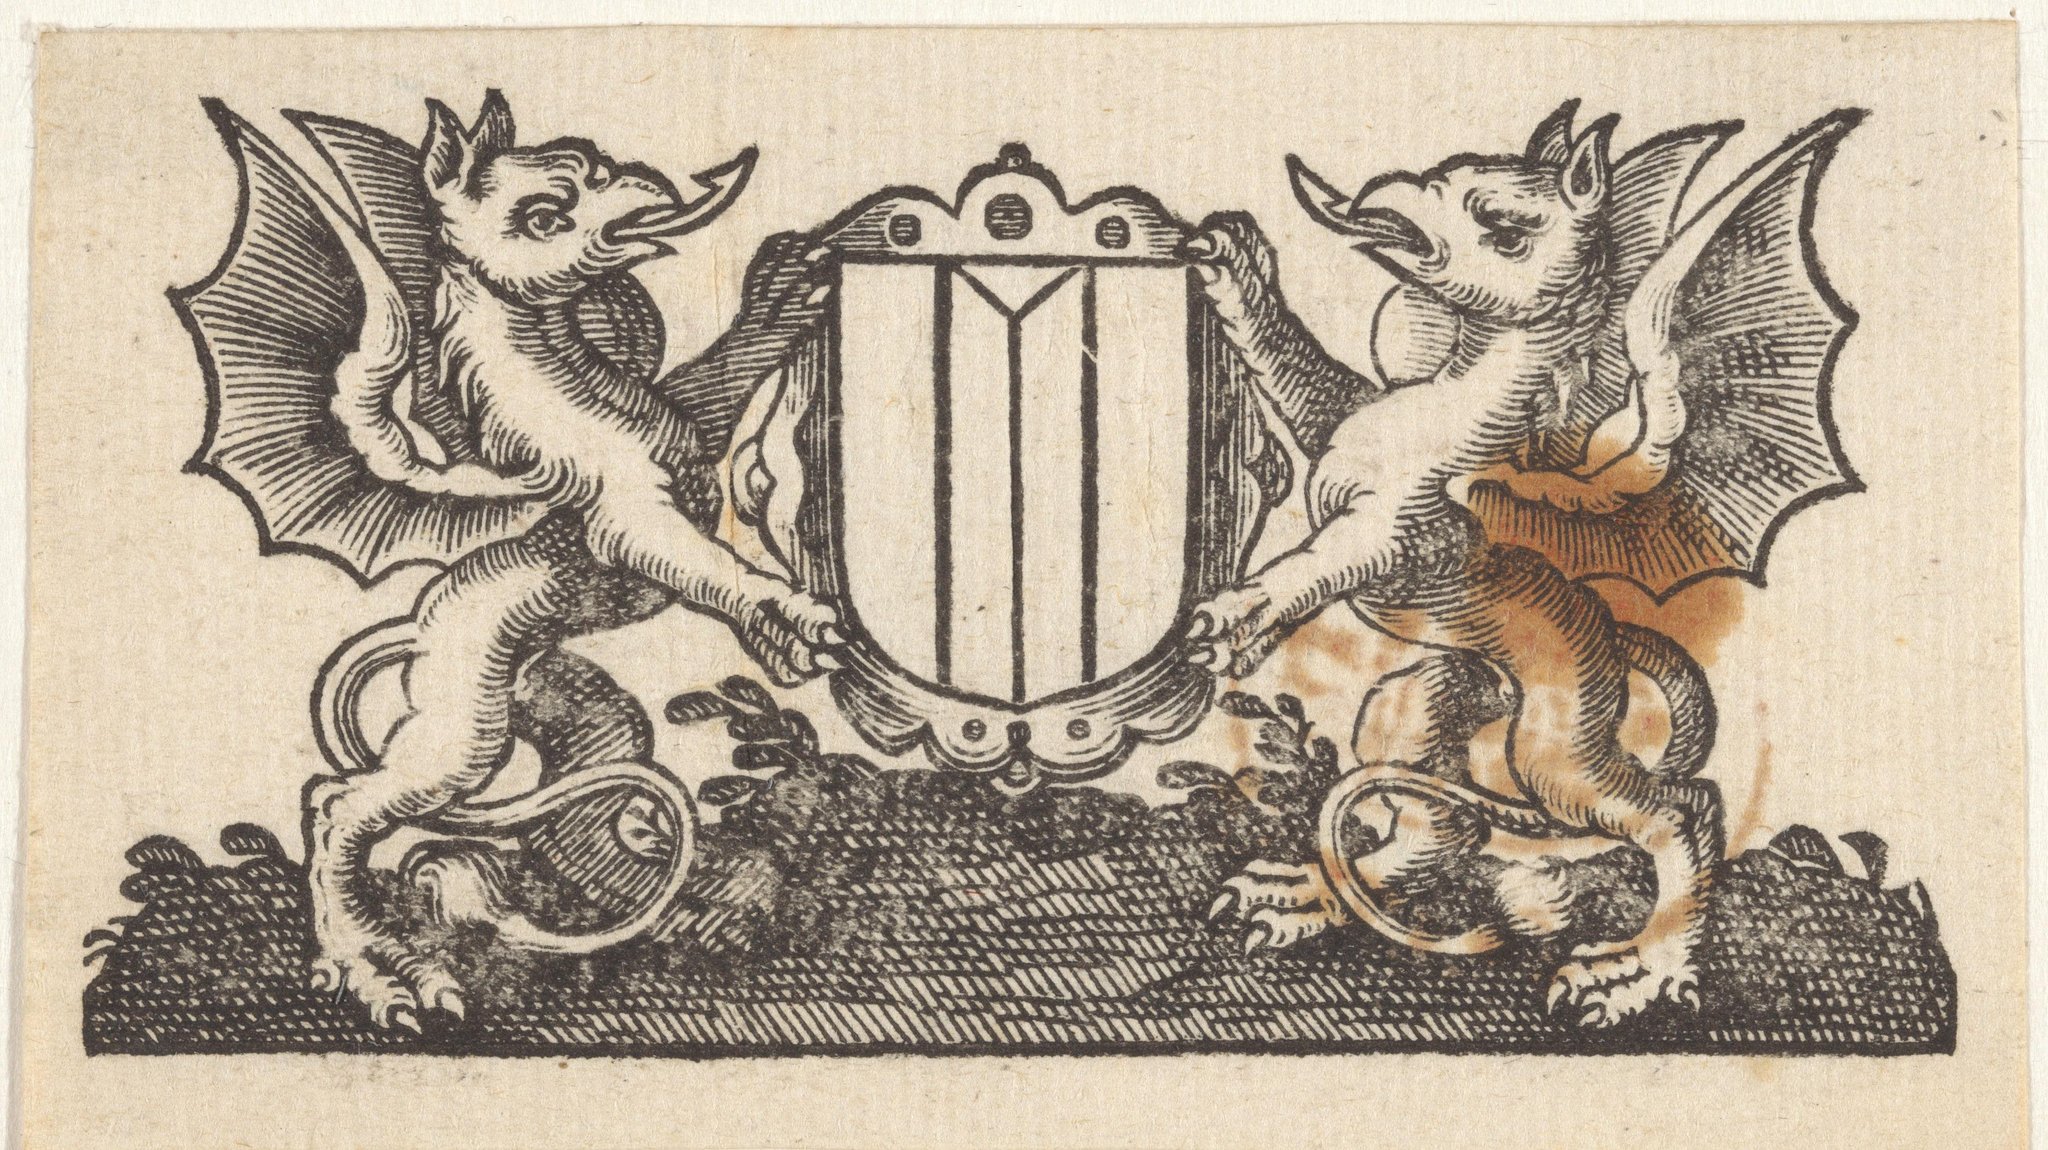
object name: print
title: Vignet met een wapen en twee griffioenen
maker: Anonymous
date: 1600-1699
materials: paper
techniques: woodcut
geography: netherlands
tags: coat of arms (as symbol of the state, etc.), griffin (lion/eagle); 'griffo' (ripa), vignette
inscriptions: collector's mark: Lugt 240